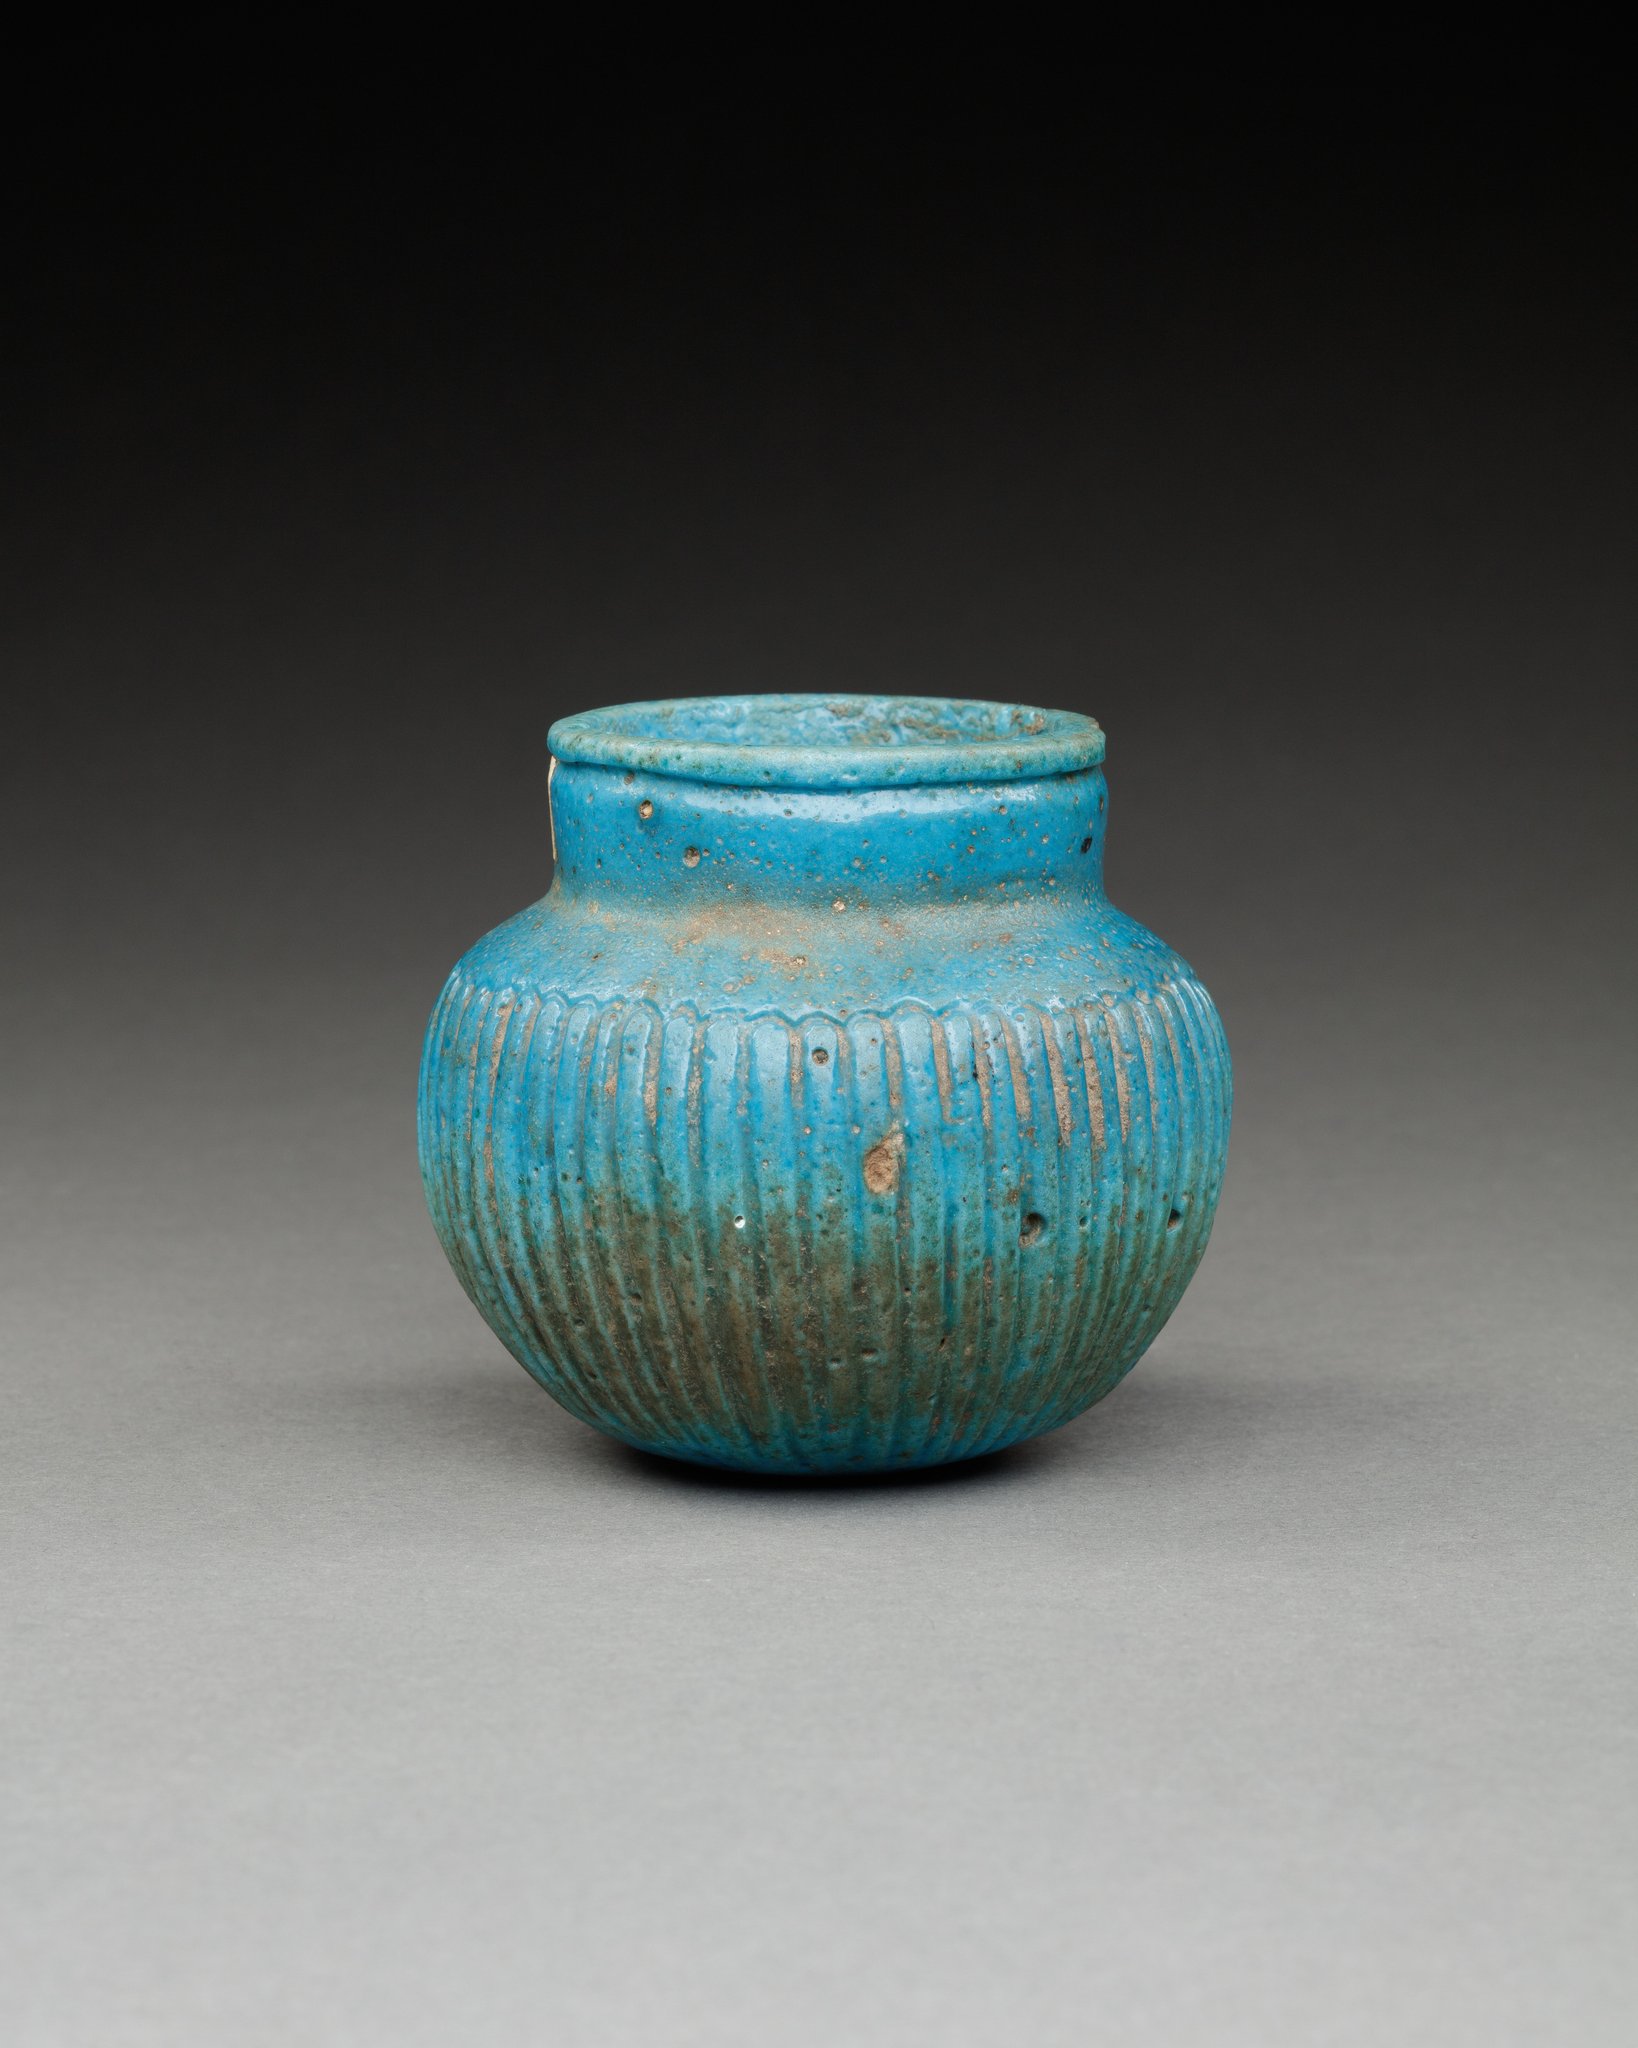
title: Faience Ribbed Jar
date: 1550-1070 BCE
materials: faience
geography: egypt